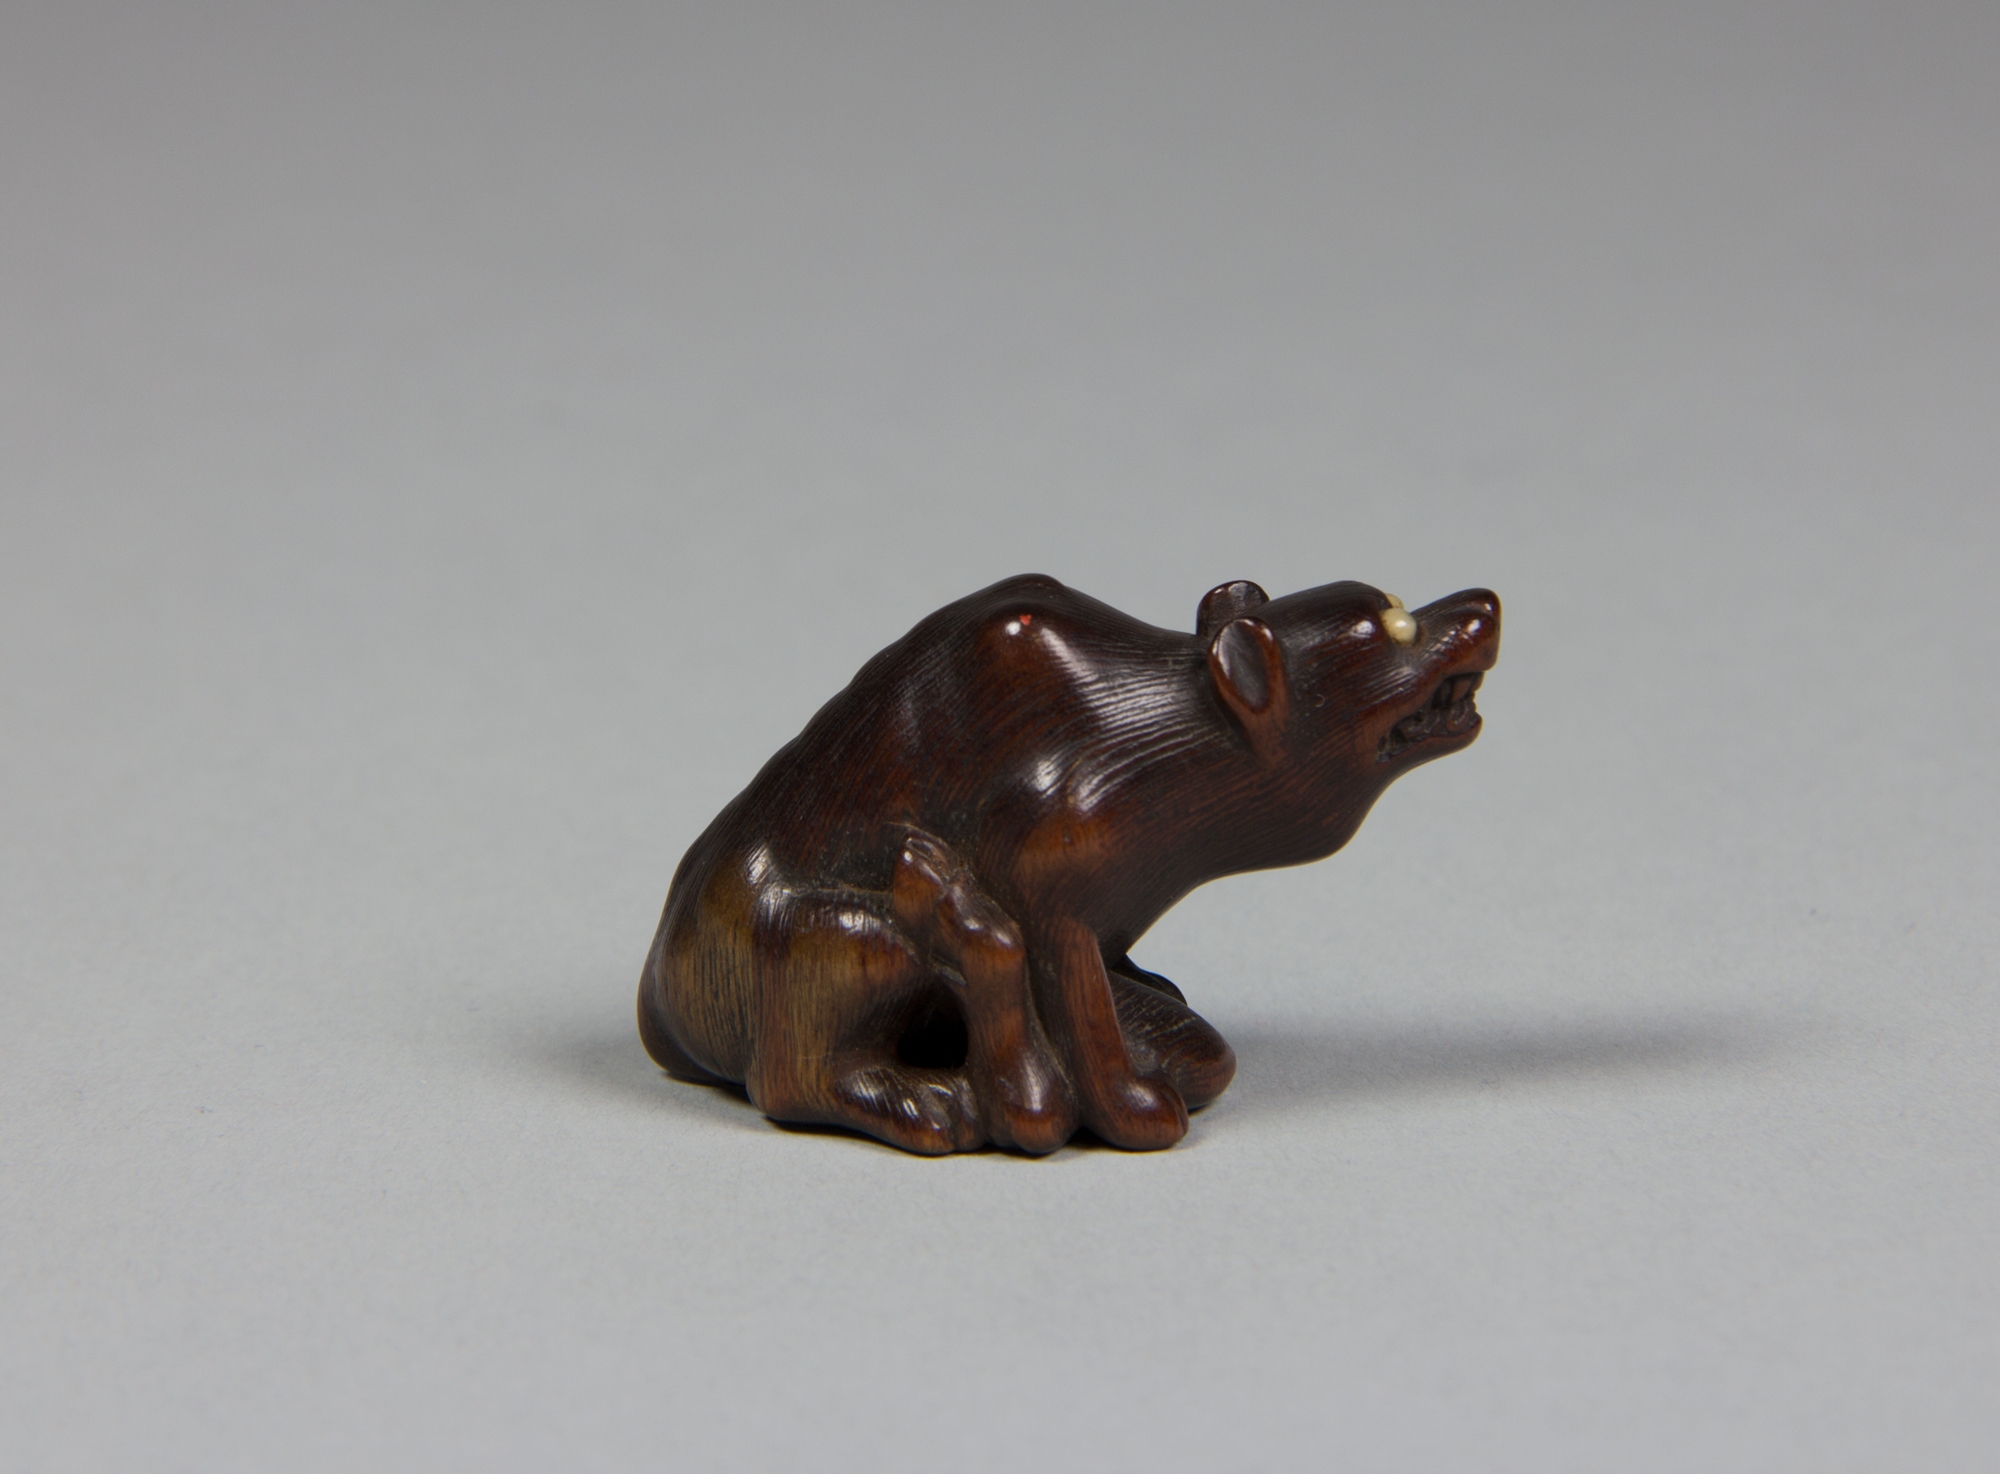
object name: netsuke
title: Netsuke of a Wolf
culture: japanese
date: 1801-1900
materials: glass, wood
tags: animals